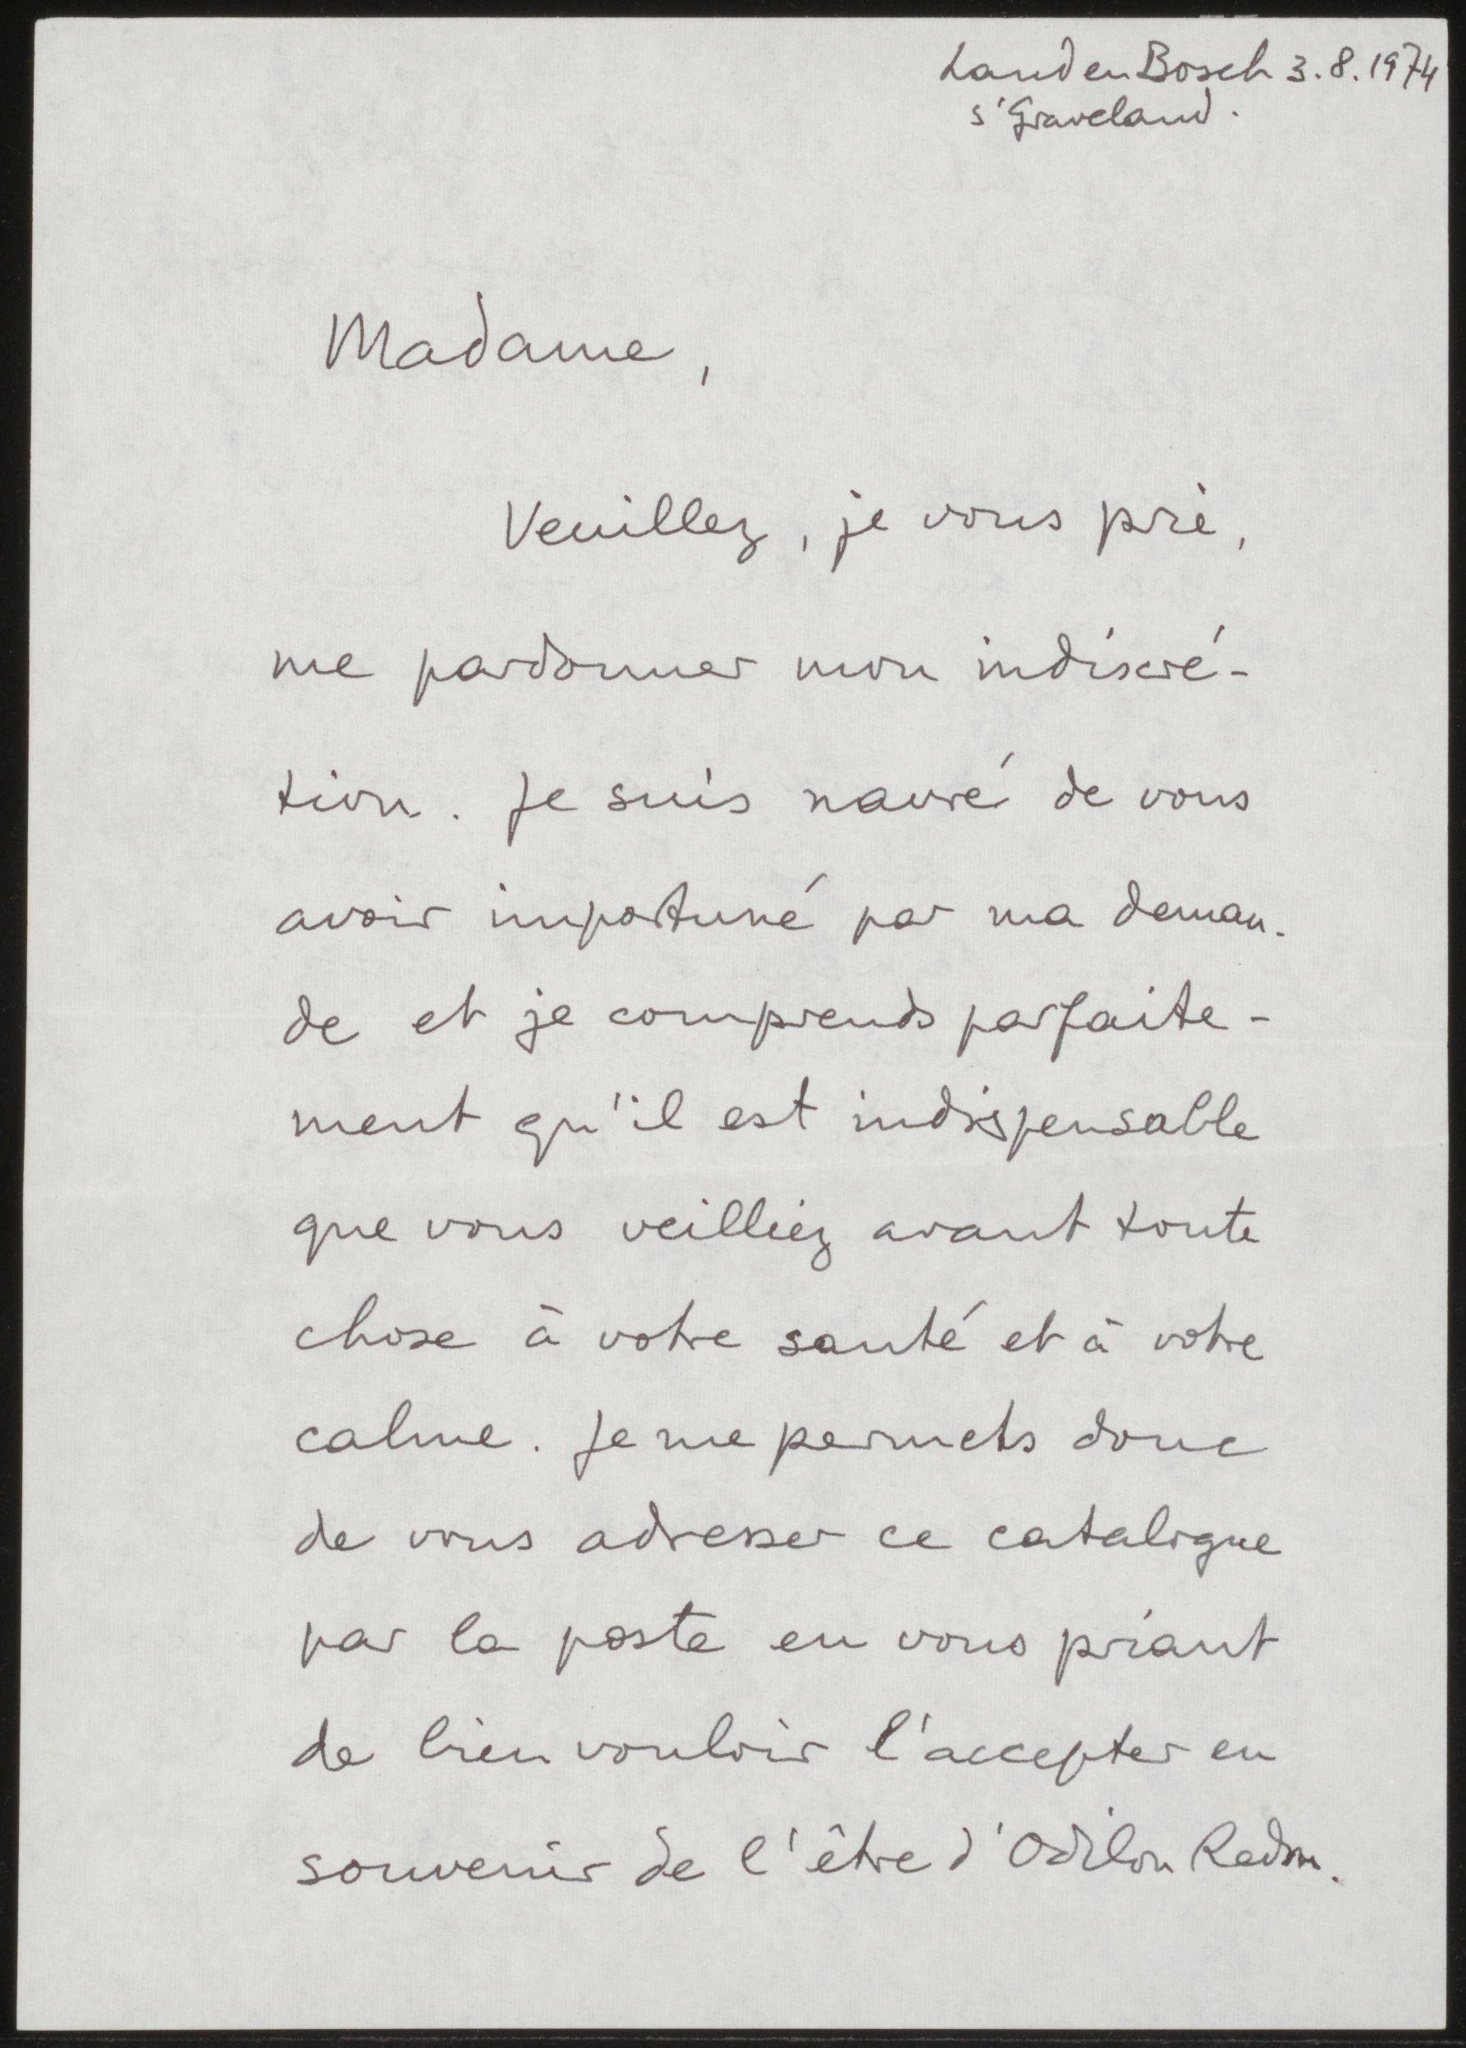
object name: letter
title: Brief aan Françoise W.M. Bonger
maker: g. klockenbring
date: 1974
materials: ink, paper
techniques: pen, writing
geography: s-graveland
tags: paris, painter, print maker, draughtsman, odilon redon, françoise w.m. bonger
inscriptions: watermark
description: Bij de brief worden enkele "Communaute des chretiens" bewaard.